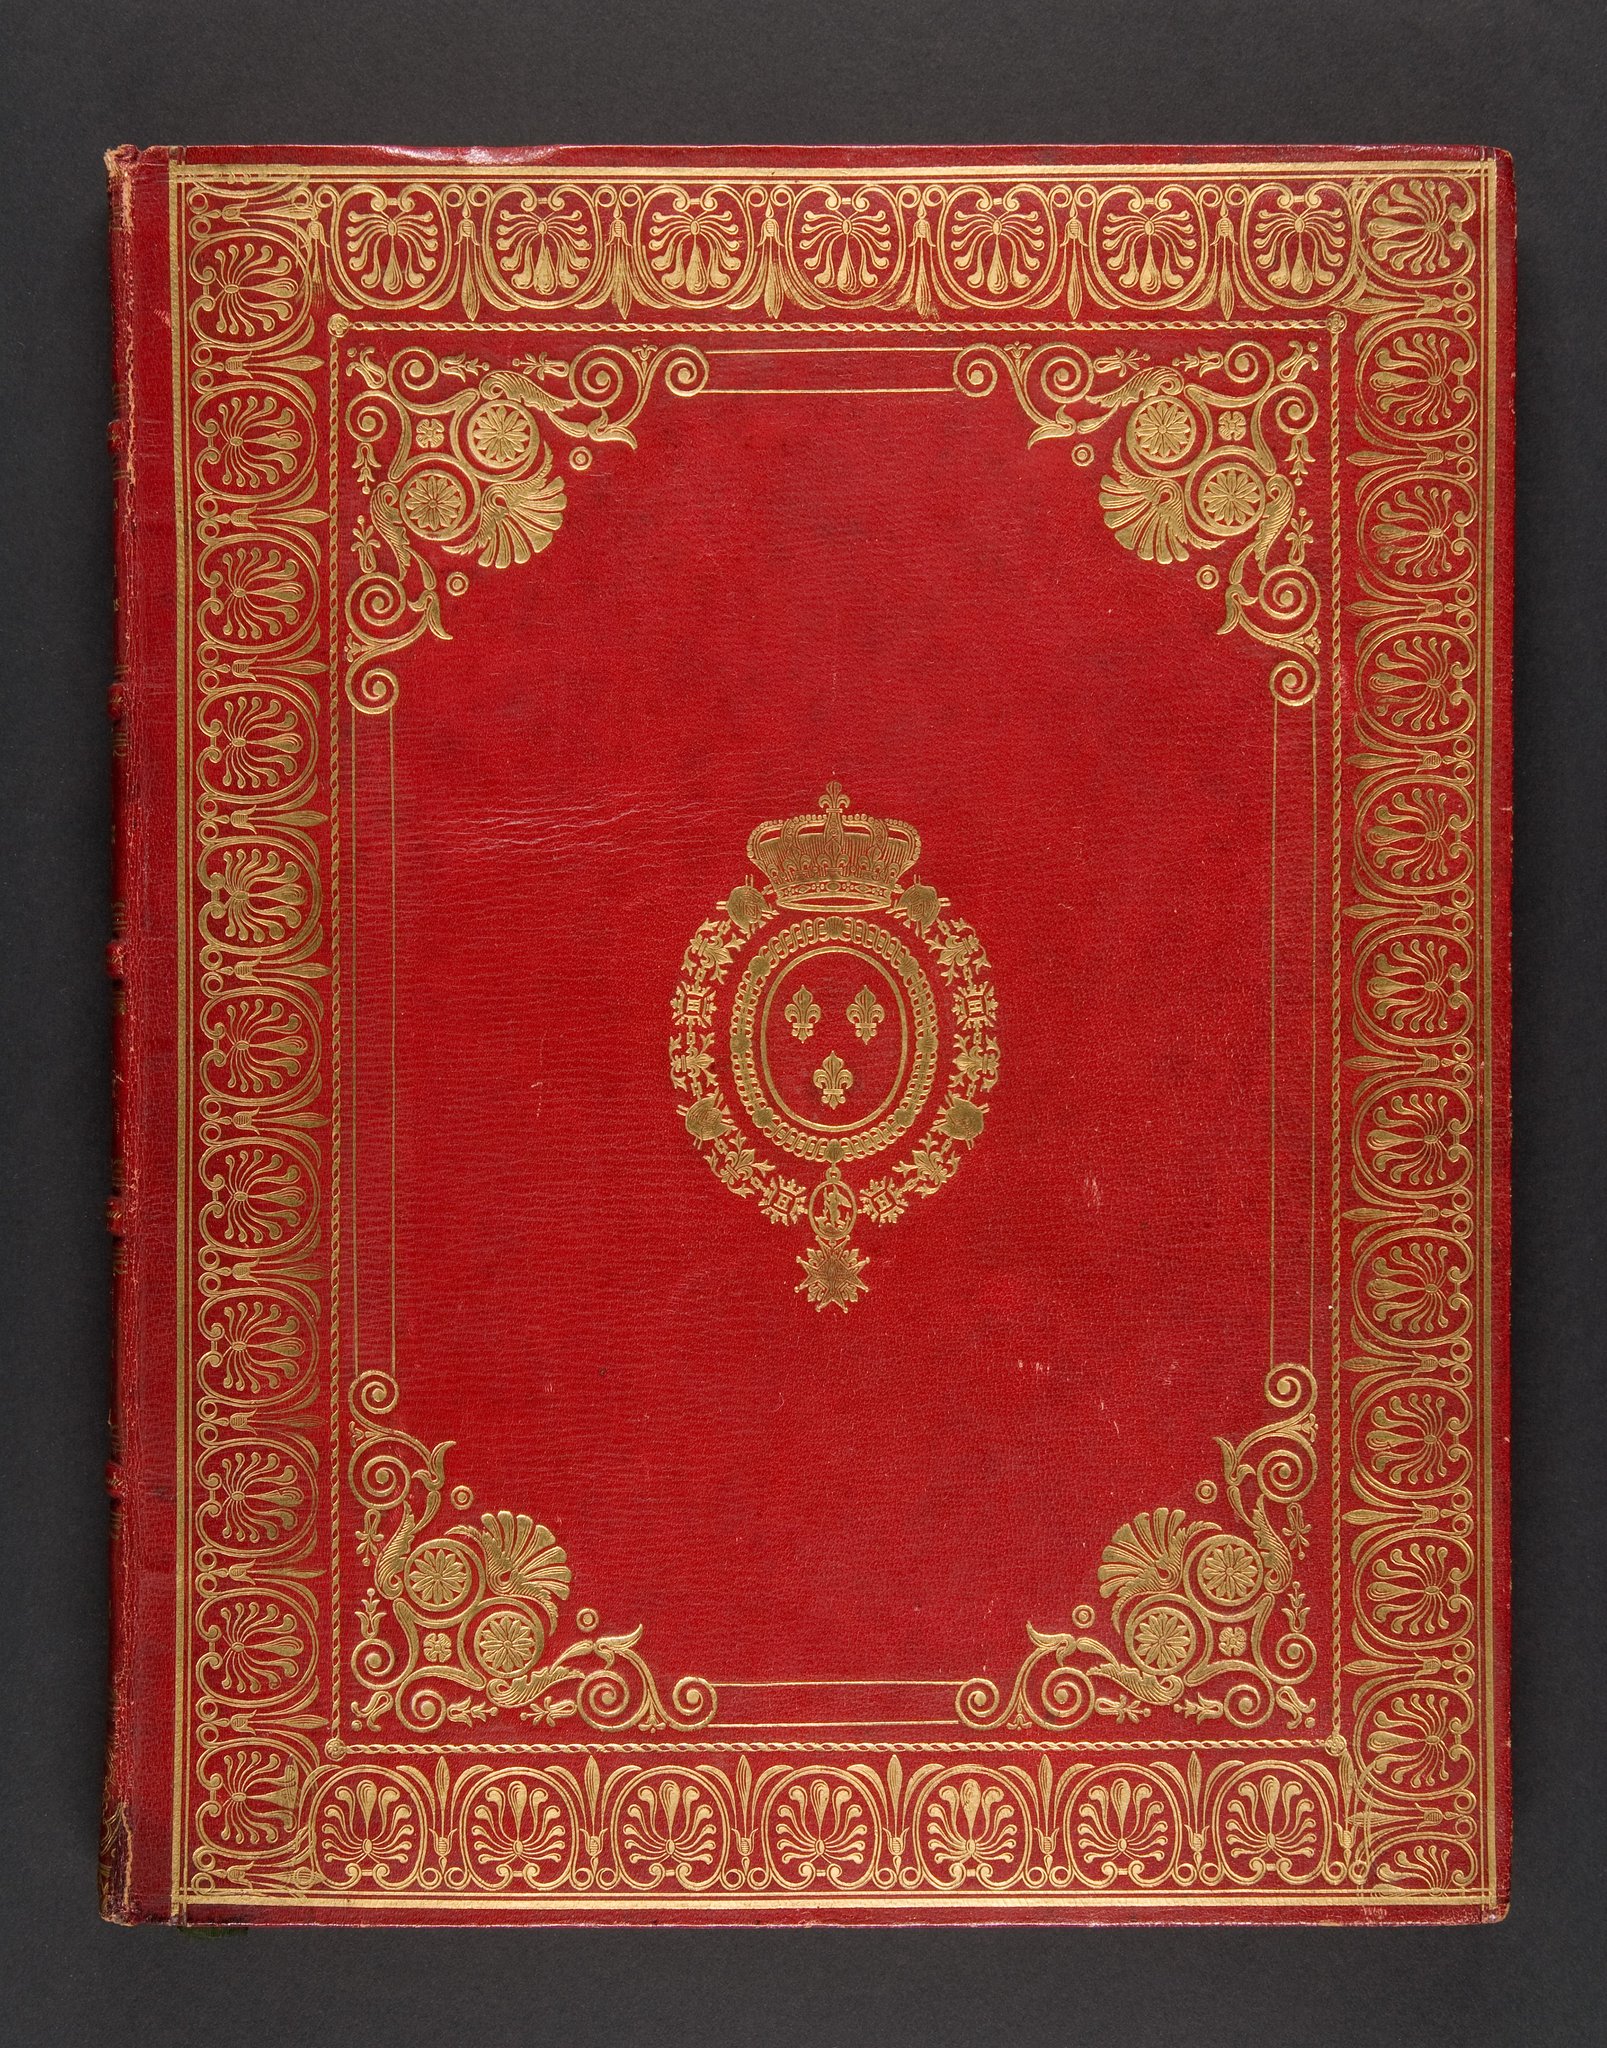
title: Rapport au roi sur la situation, au 31 mars, 1829, des canaux et autres ouvrages entrepris en vertu des lois des 20 juin et 5 aout 1821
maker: l'imprimerie royale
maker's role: publisher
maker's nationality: french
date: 1829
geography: france